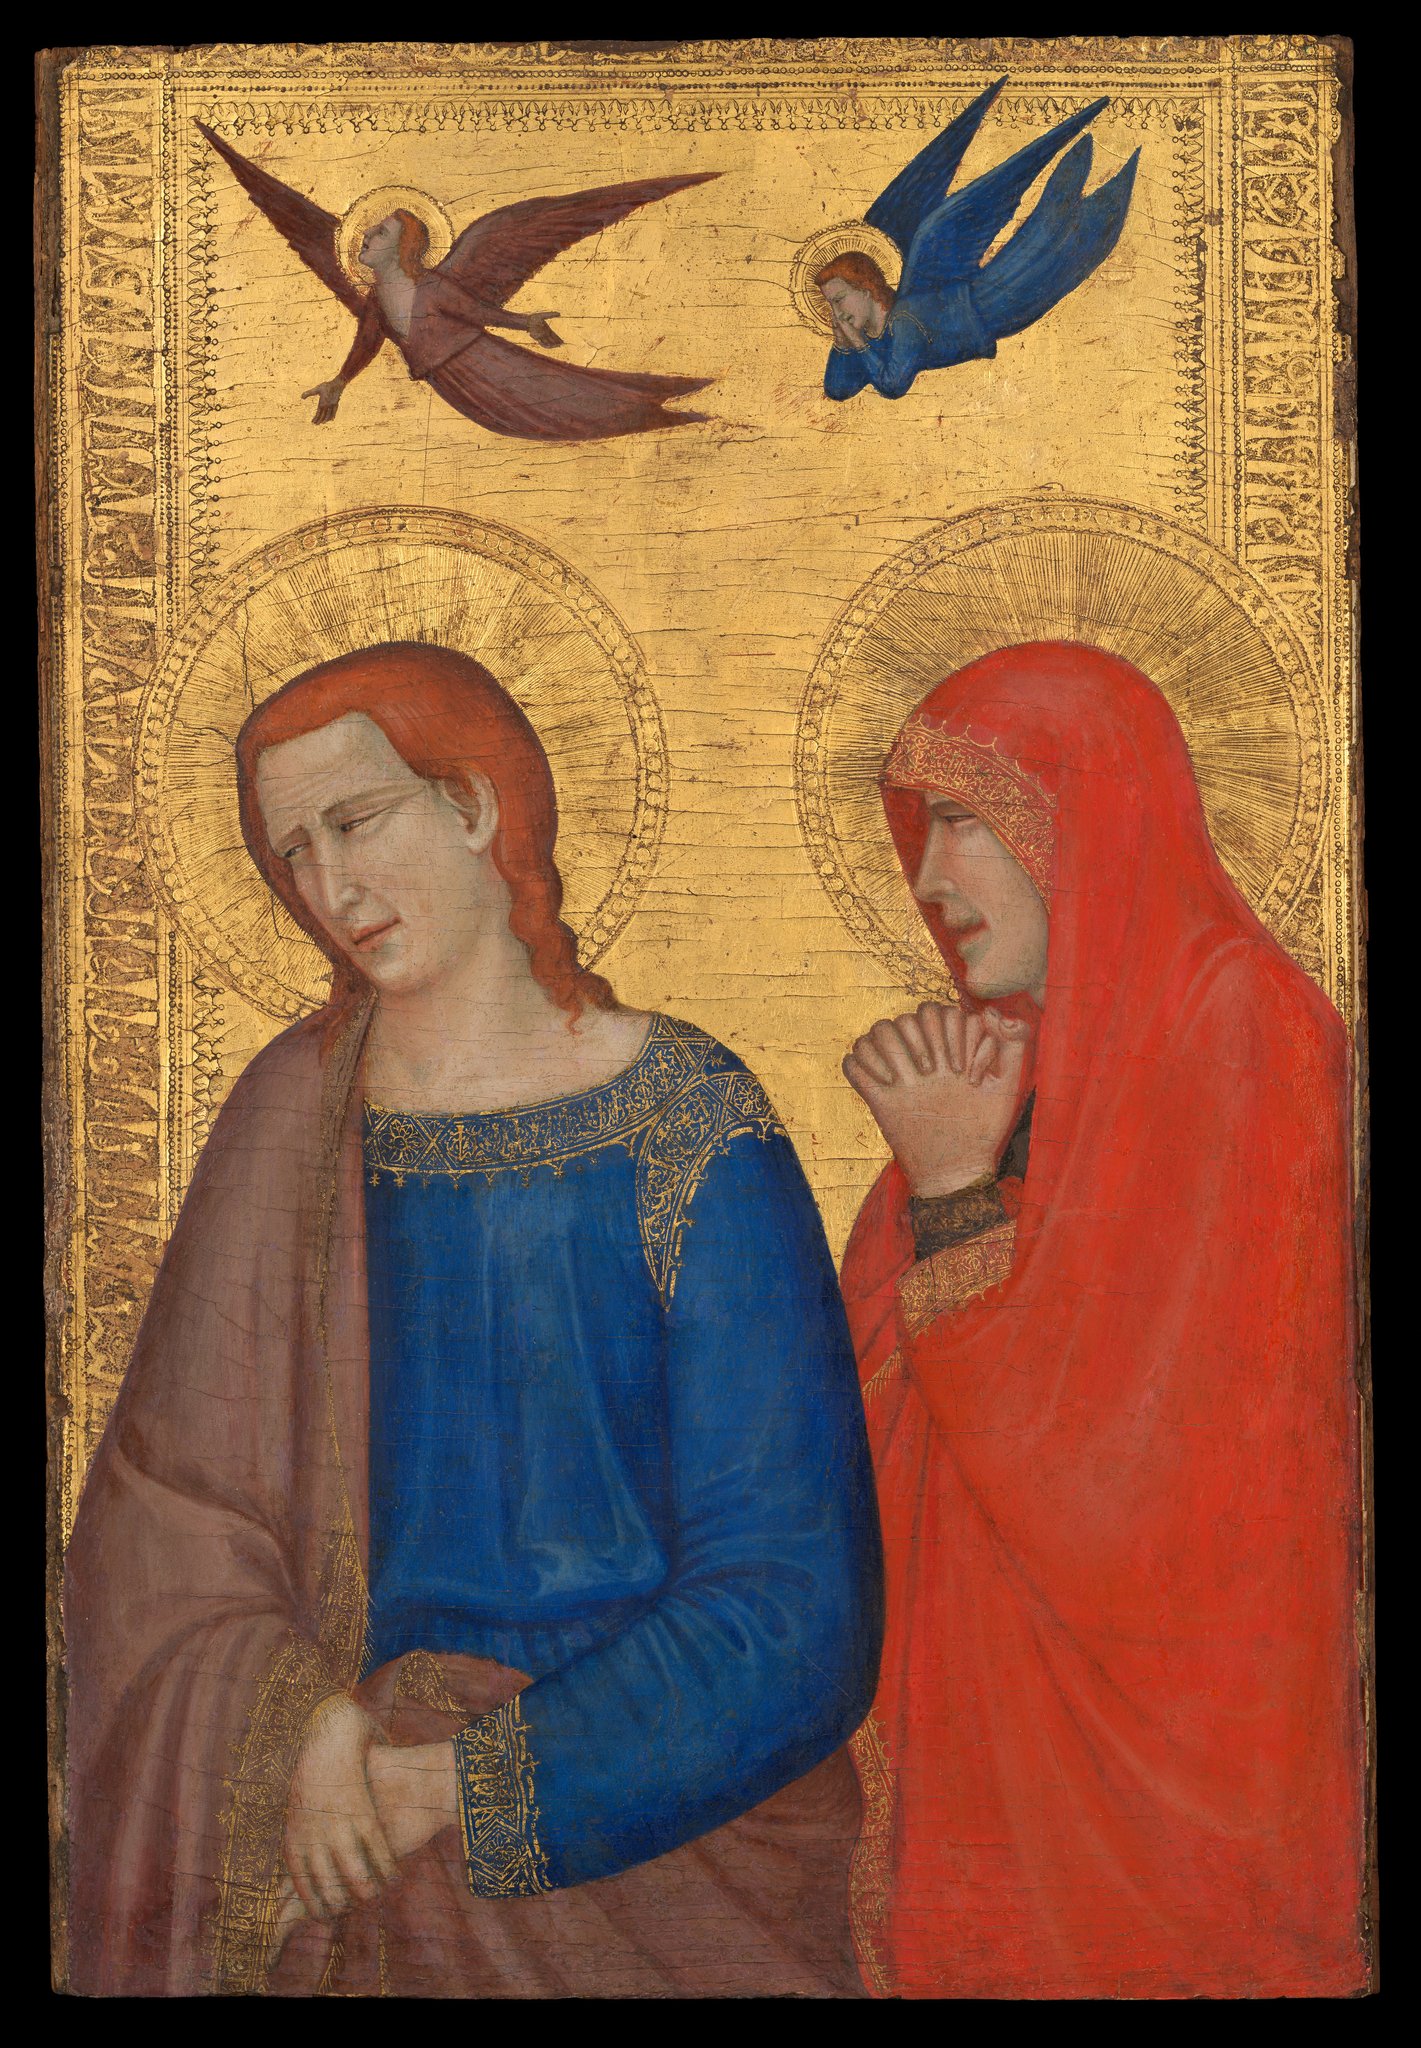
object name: painting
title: Saints John the Evangelist and Mary Magdalene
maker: italian, neapolitan follower of giotto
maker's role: artist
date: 1335-1345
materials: gold leaf, paint, wood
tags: angels,mary magdalene,saint john the evangelist